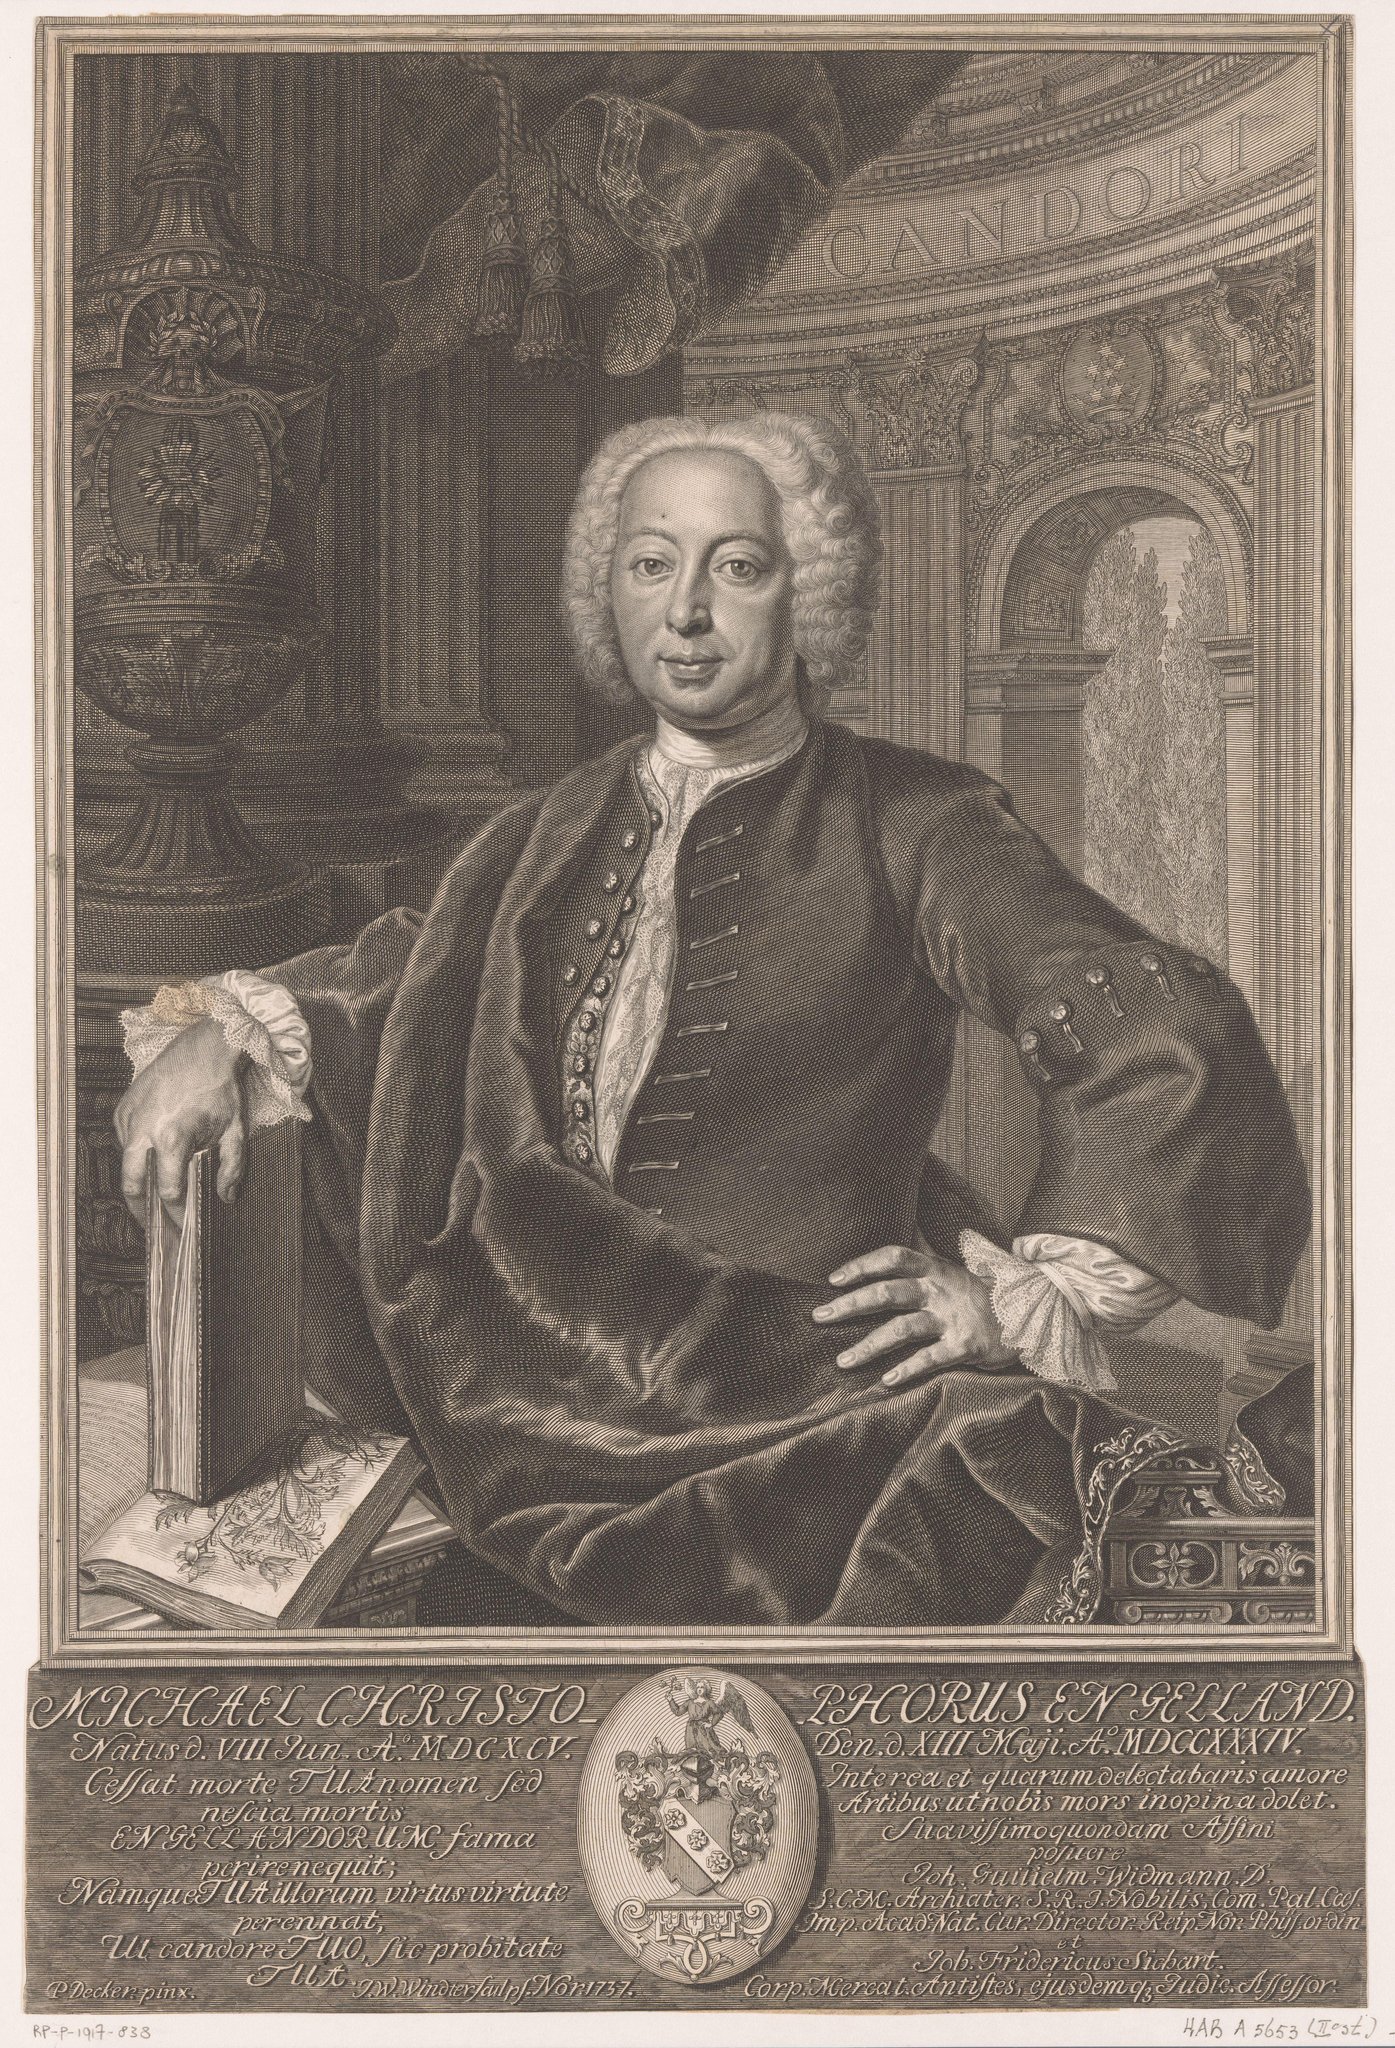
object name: print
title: Portret van Michael Christoph Engelland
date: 1737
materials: paper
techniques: engraving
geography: nuremberg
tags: historical persons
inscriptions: collector's mark: Lugt 2228